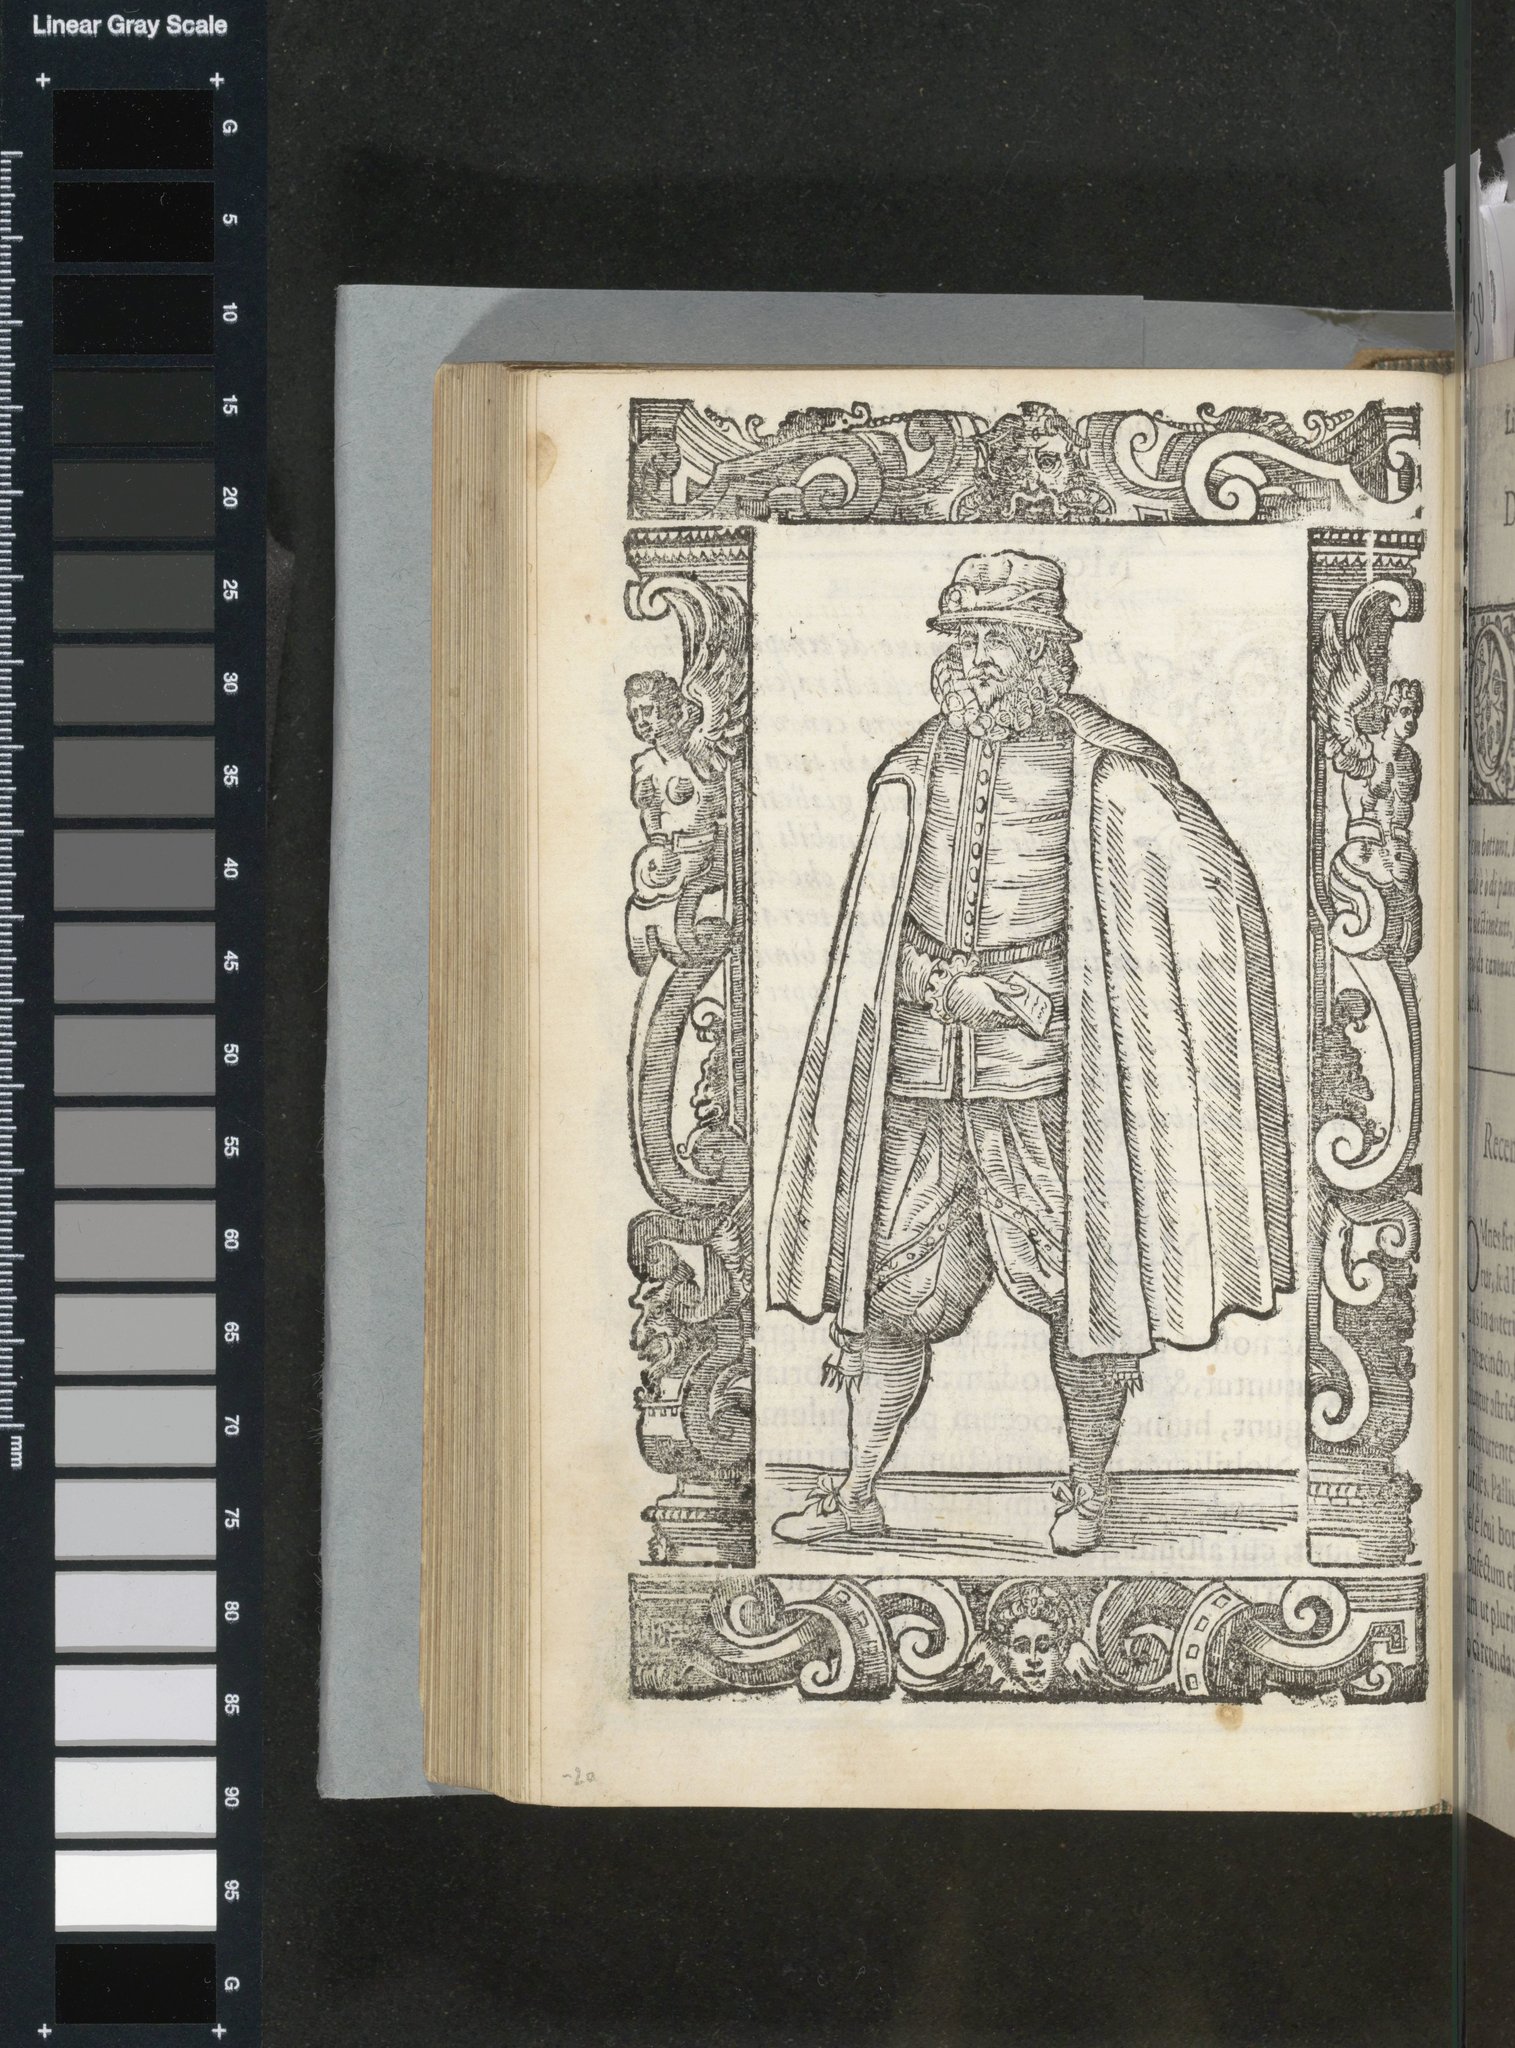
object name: costume print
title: De mercanti romani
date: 1598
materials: paper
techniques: woodcut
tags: neck-gear ~ clothing (with name) (+ men's clothes), cape (+ men's clothes), head-gear: hat (+ men's clothes), fashion plates, shoes, sandals (+ men's clothes), trousers, breeches, etc. (breeches) (+ men's clothes), clothing for the upper part of the body (doublet) (+ men's clothes)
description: Romeins koopman, naar links, gekleed in wijde schoudermantel over wambuis en poffende kniebroek. Hoed op het hoofd. In ornamentrand.